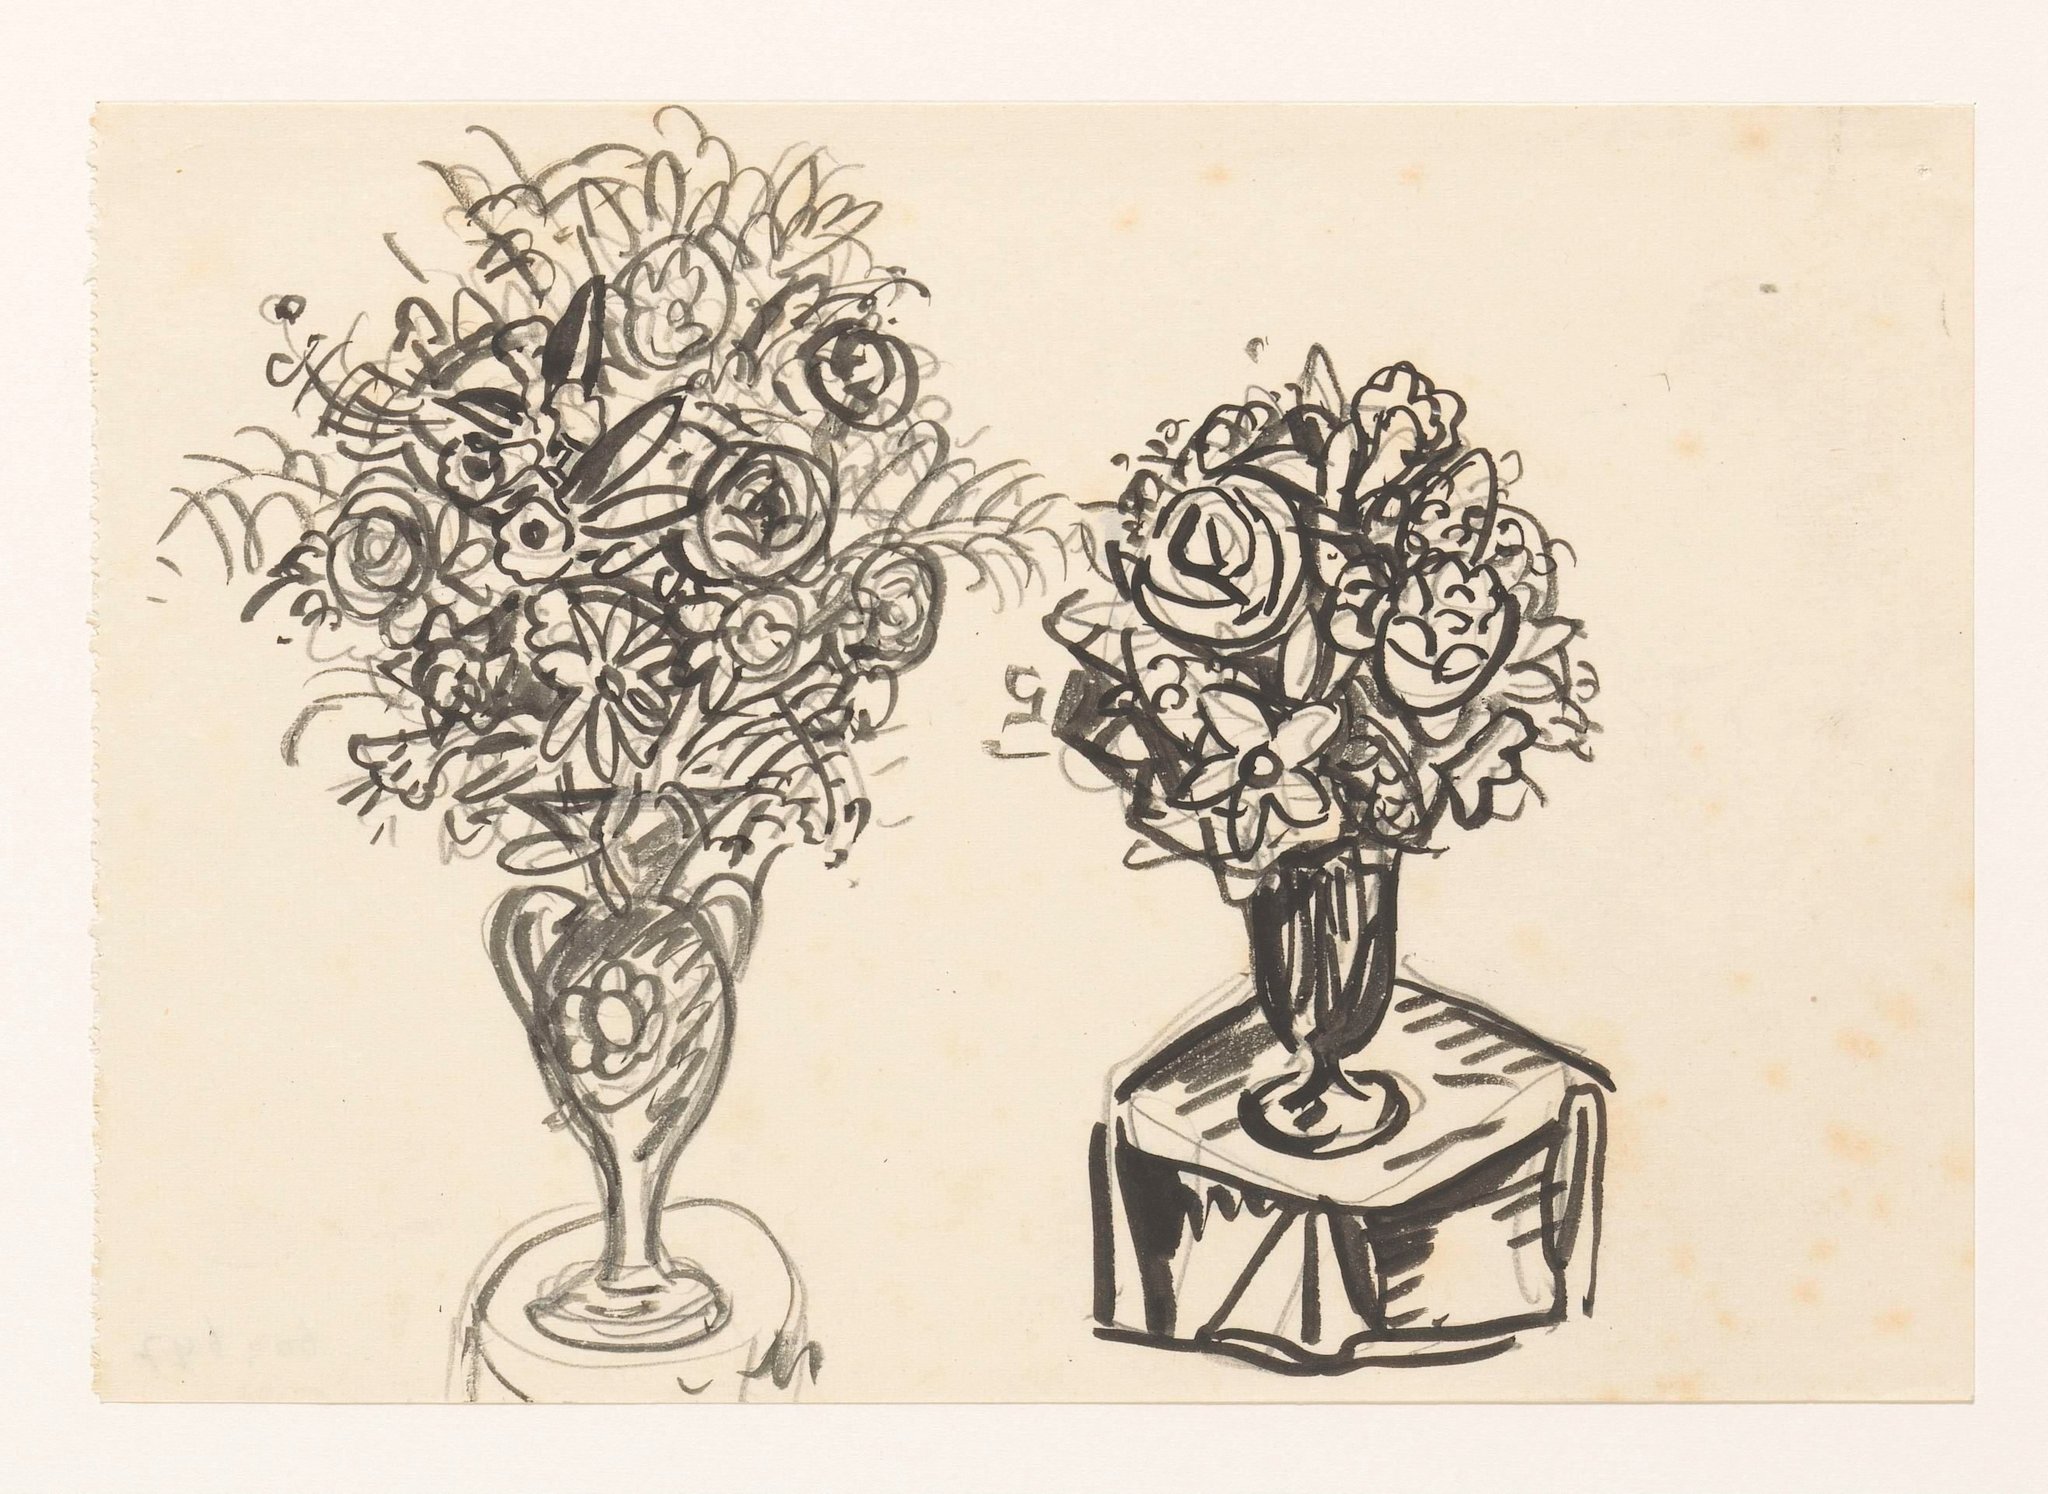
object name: drawing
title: Twee bloemenvazen op tafels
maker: leo gestel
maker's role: draughtsman, print maker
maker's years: 1881-1941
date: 1891-1941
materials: paper, pencil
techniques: brush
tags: flowers in a vase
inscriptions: collector's mark: Lugt 2228